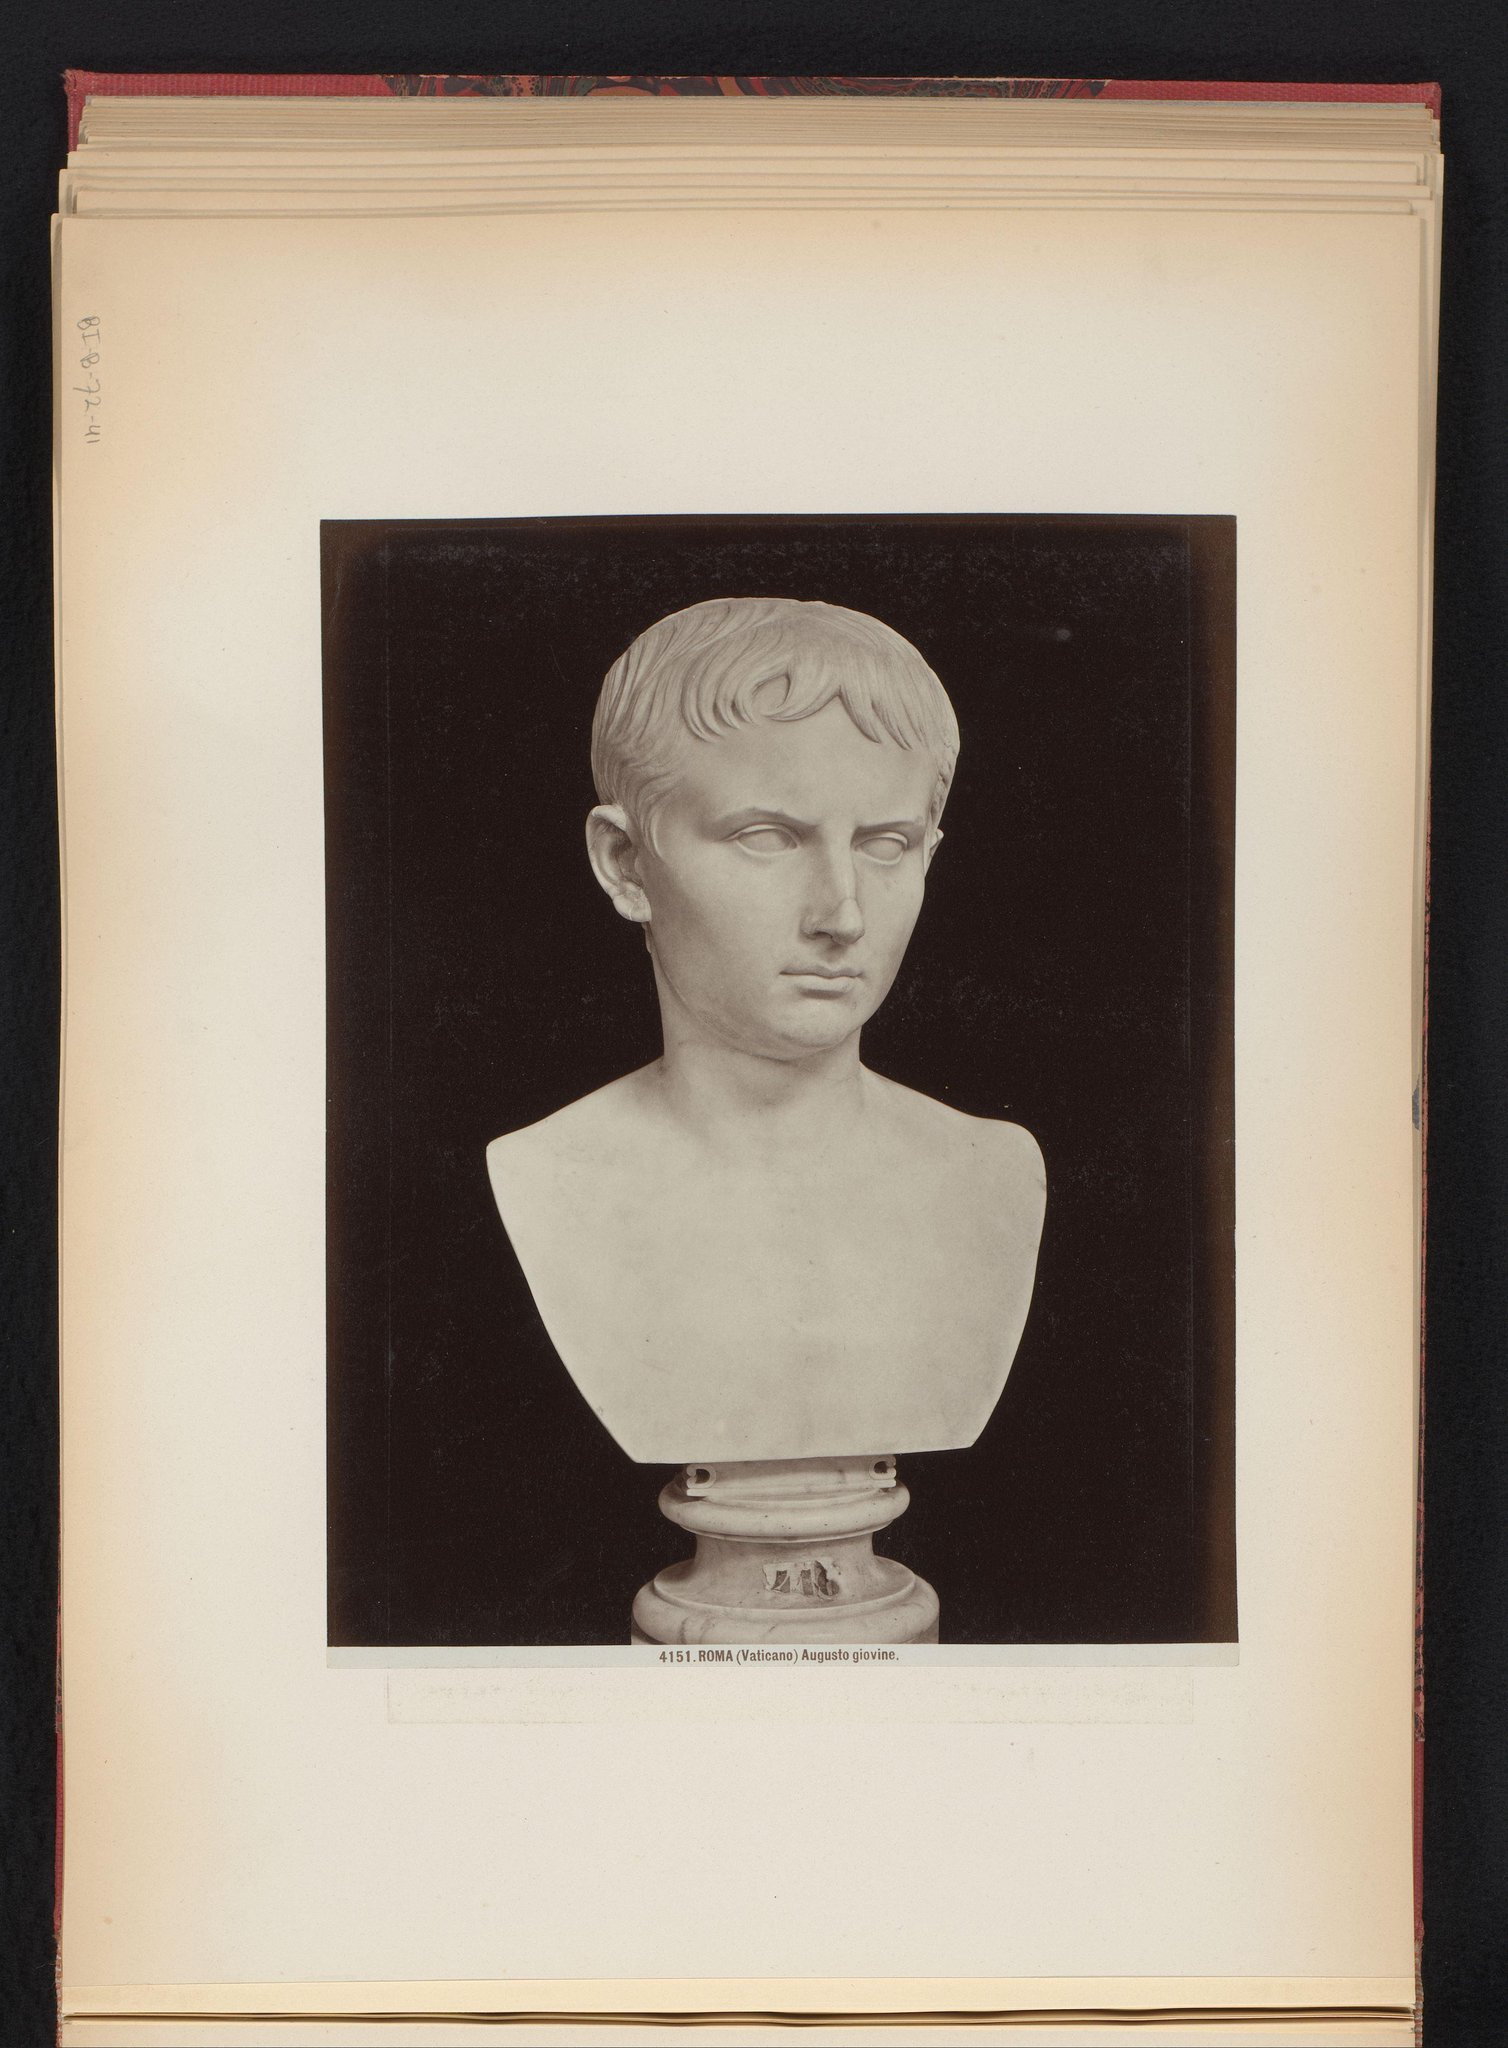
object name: photograph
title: Roma (Vaticano) Augusto giovine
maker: giacomo brogi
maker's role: fotograaf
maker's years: 1822-1881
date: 1870-1881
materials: paper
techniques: albumen print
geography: vatican city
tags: piece of sculpture, reproduction of a piece of sculpture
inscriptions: number: ‘4151.’